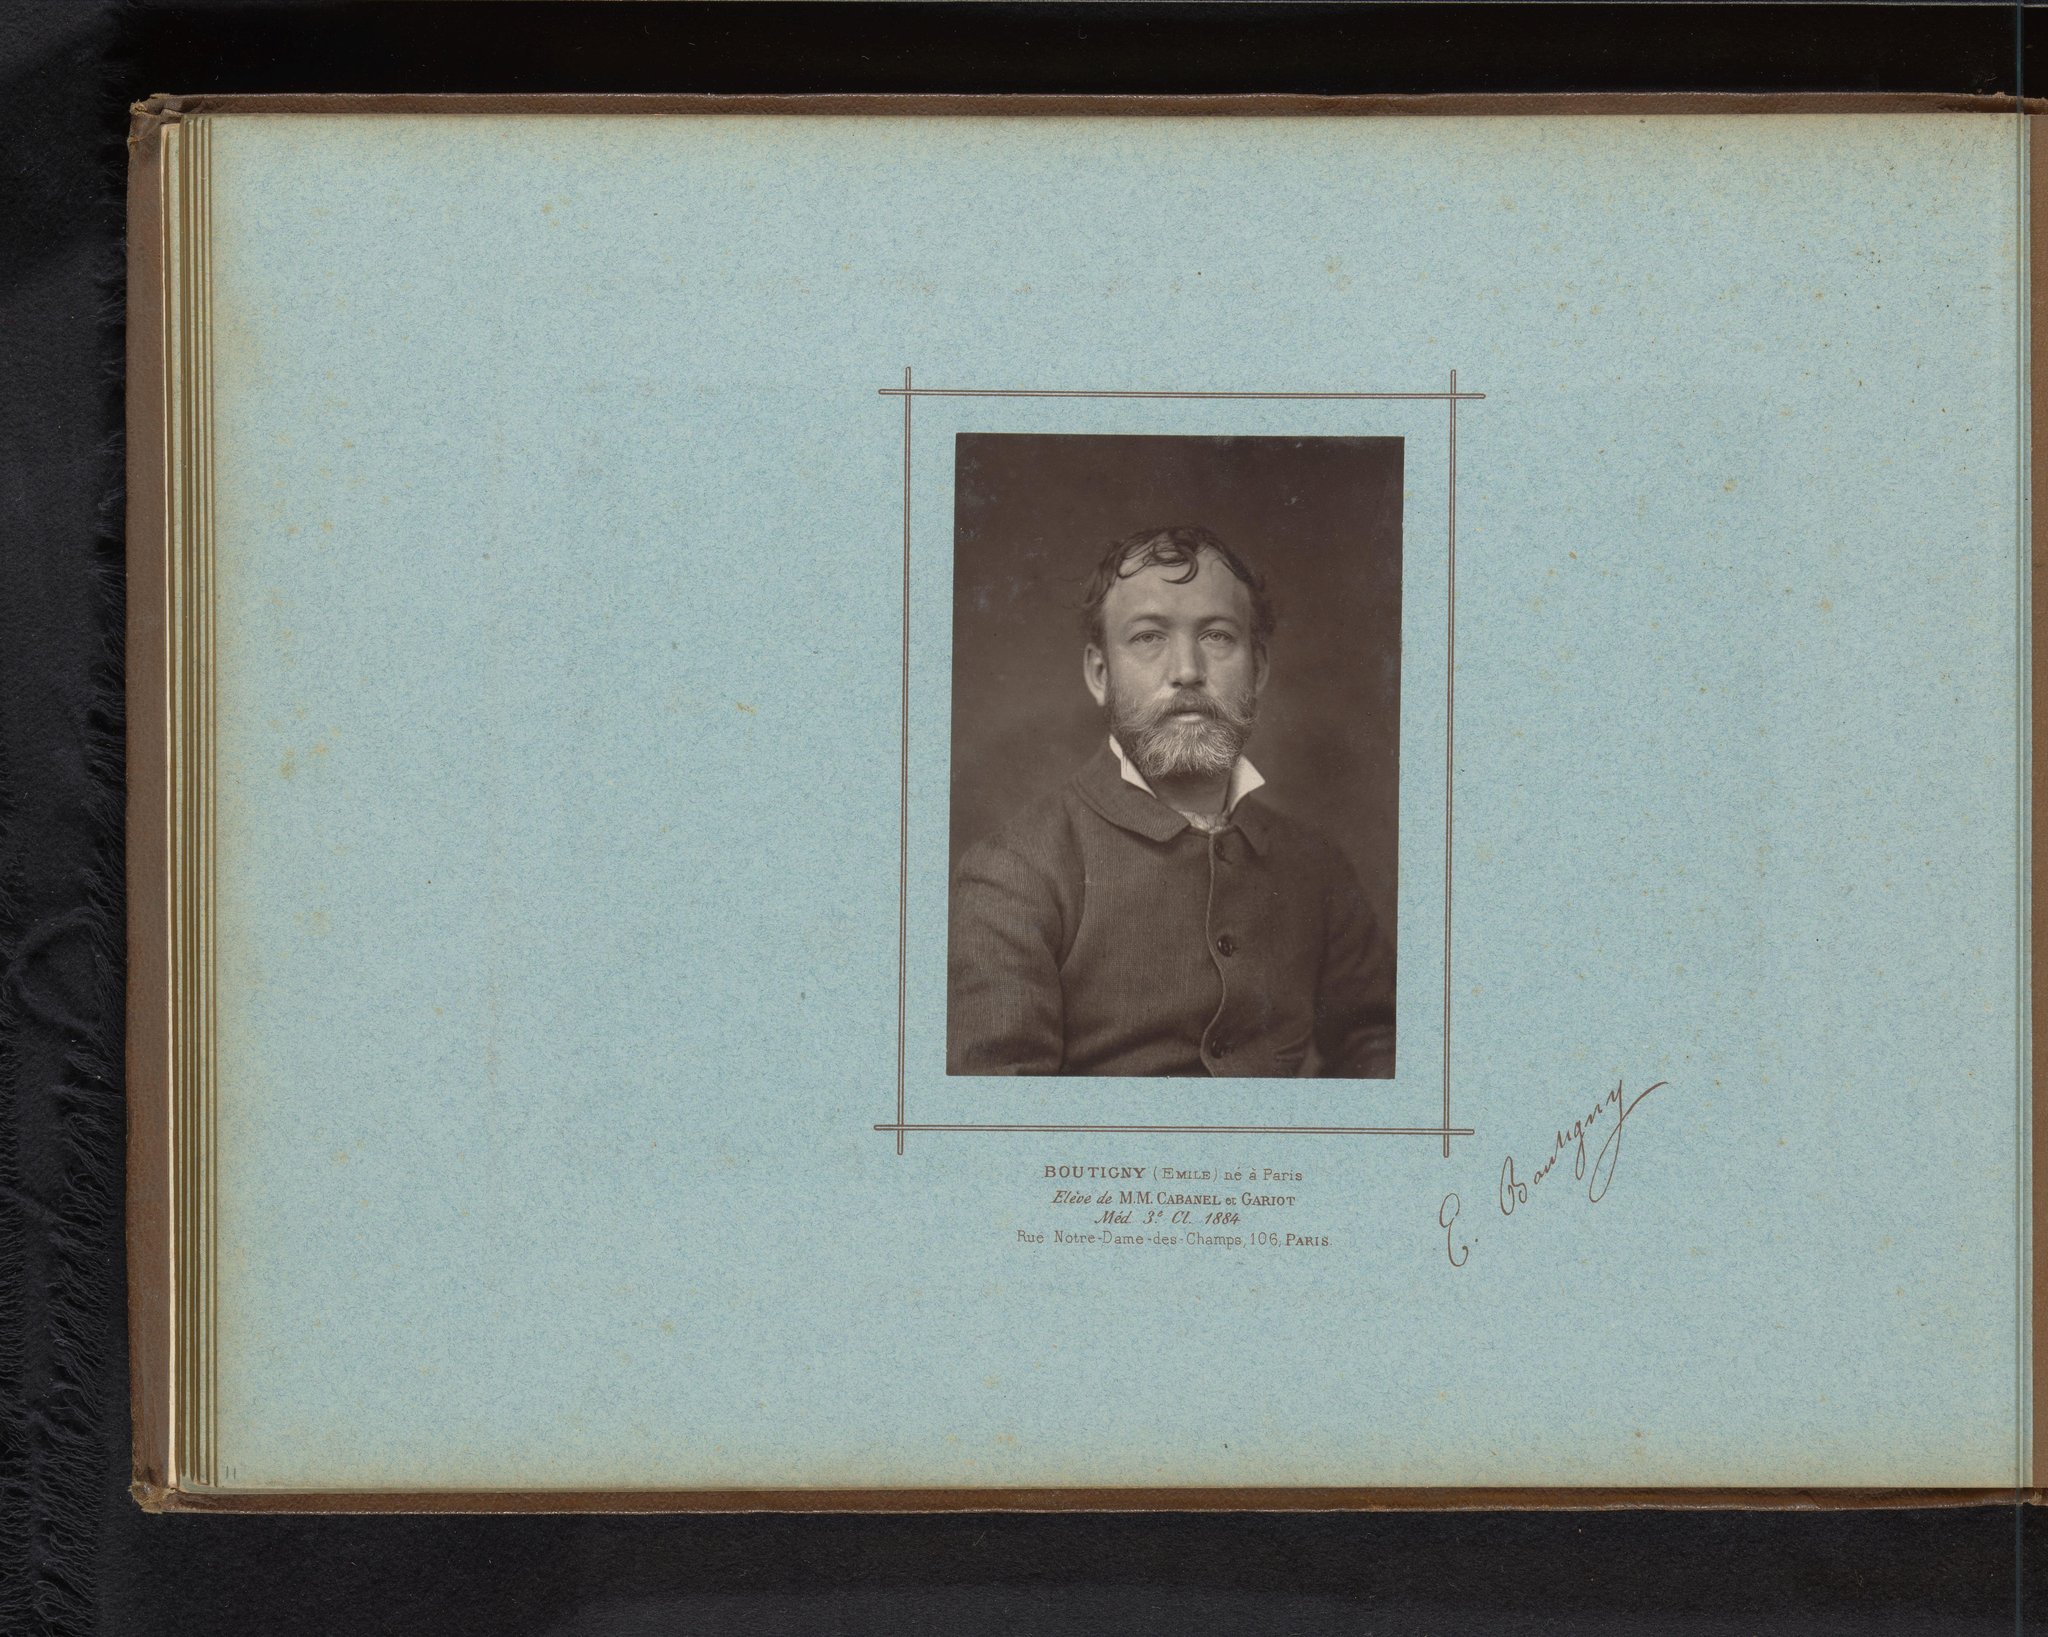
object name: page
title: Portret van Paul Emile Boutigny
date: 1879-1884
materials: paper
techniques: woodburytype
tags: paris, painter, draughtsman, paul emile boutigny, historical persons, portrait, self-portrait of painter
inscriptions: signature: ‘E. Boutigny’, inscription: ‘BOUTIGNY (Emile) né à Paris/ Élève de M.M. Cabanal et Gariot/ Méd. 3e. Cl. 1884/ Rue Notre-Dame-des-Champs, 106, Paris’